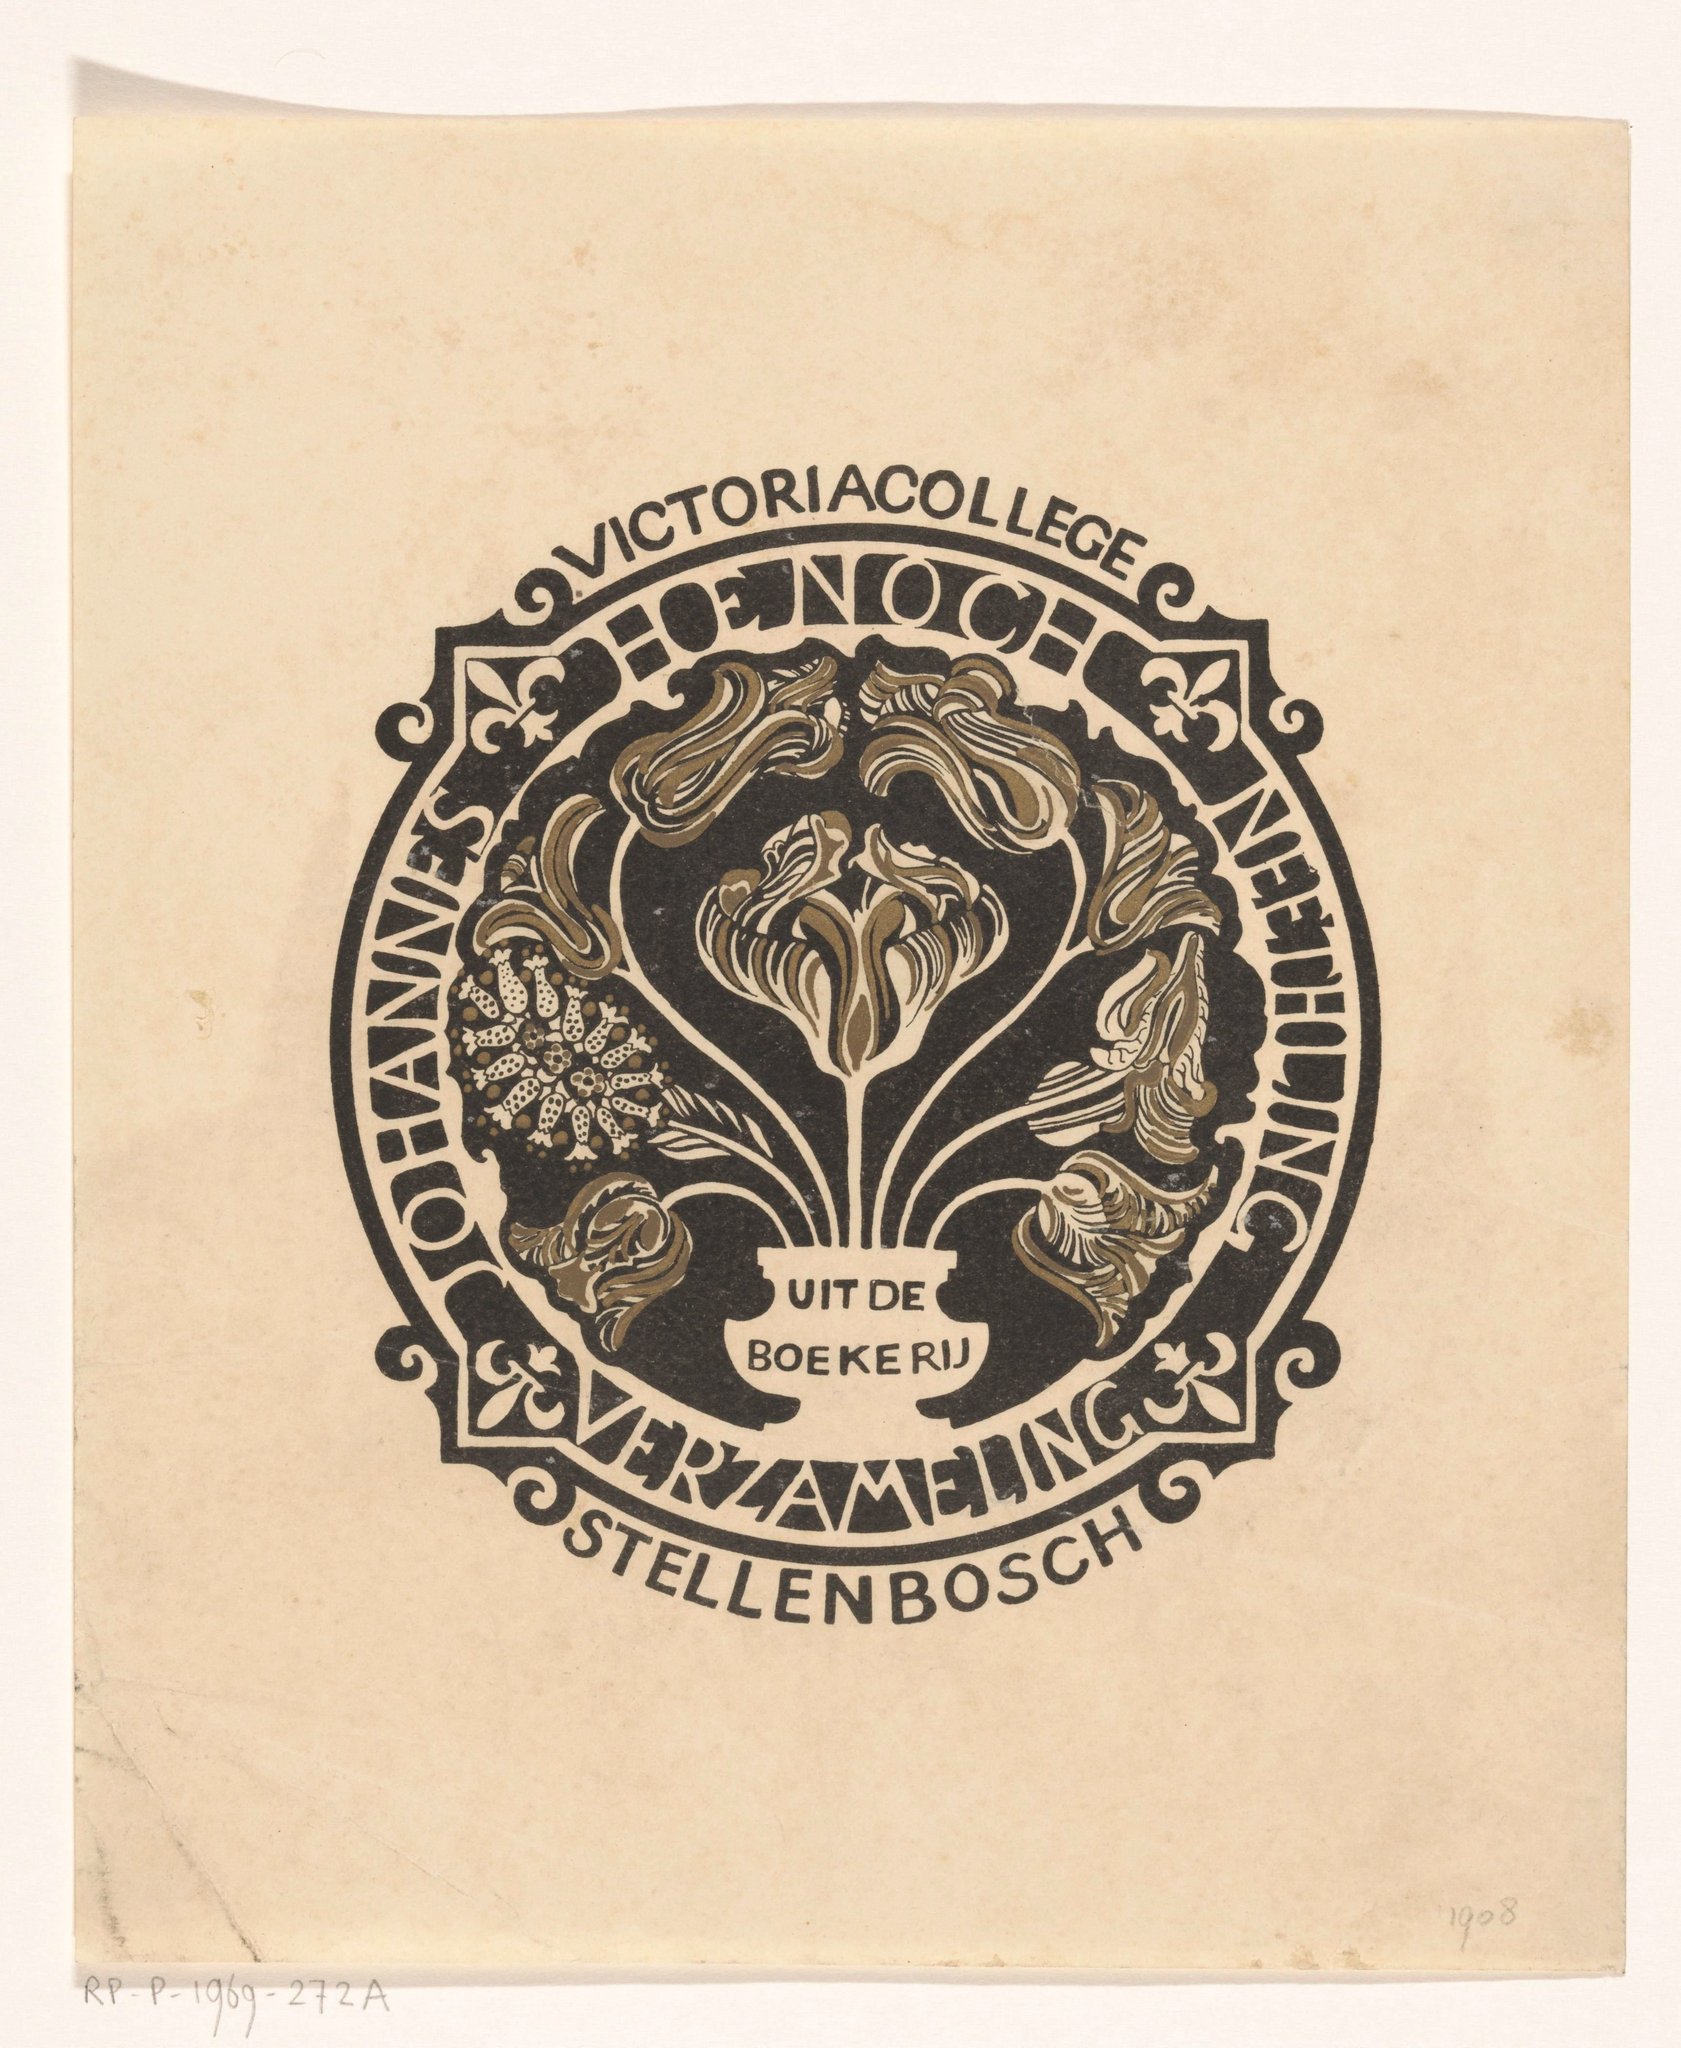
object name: bookplate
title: Ex libris van de Johannes Henoch Neethling verzameling ondergebracht bij Victoria College in Stellenbosch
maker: carel adolph lion cachet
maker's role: draughtsman, print maker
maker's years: 1864-1945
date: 1909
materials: paper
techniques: printing block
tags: flowers in a vase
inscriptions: collector's mark: Lugt 2228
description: Een bloemenvaas met daarop de tekst 'uit de boekerij'.